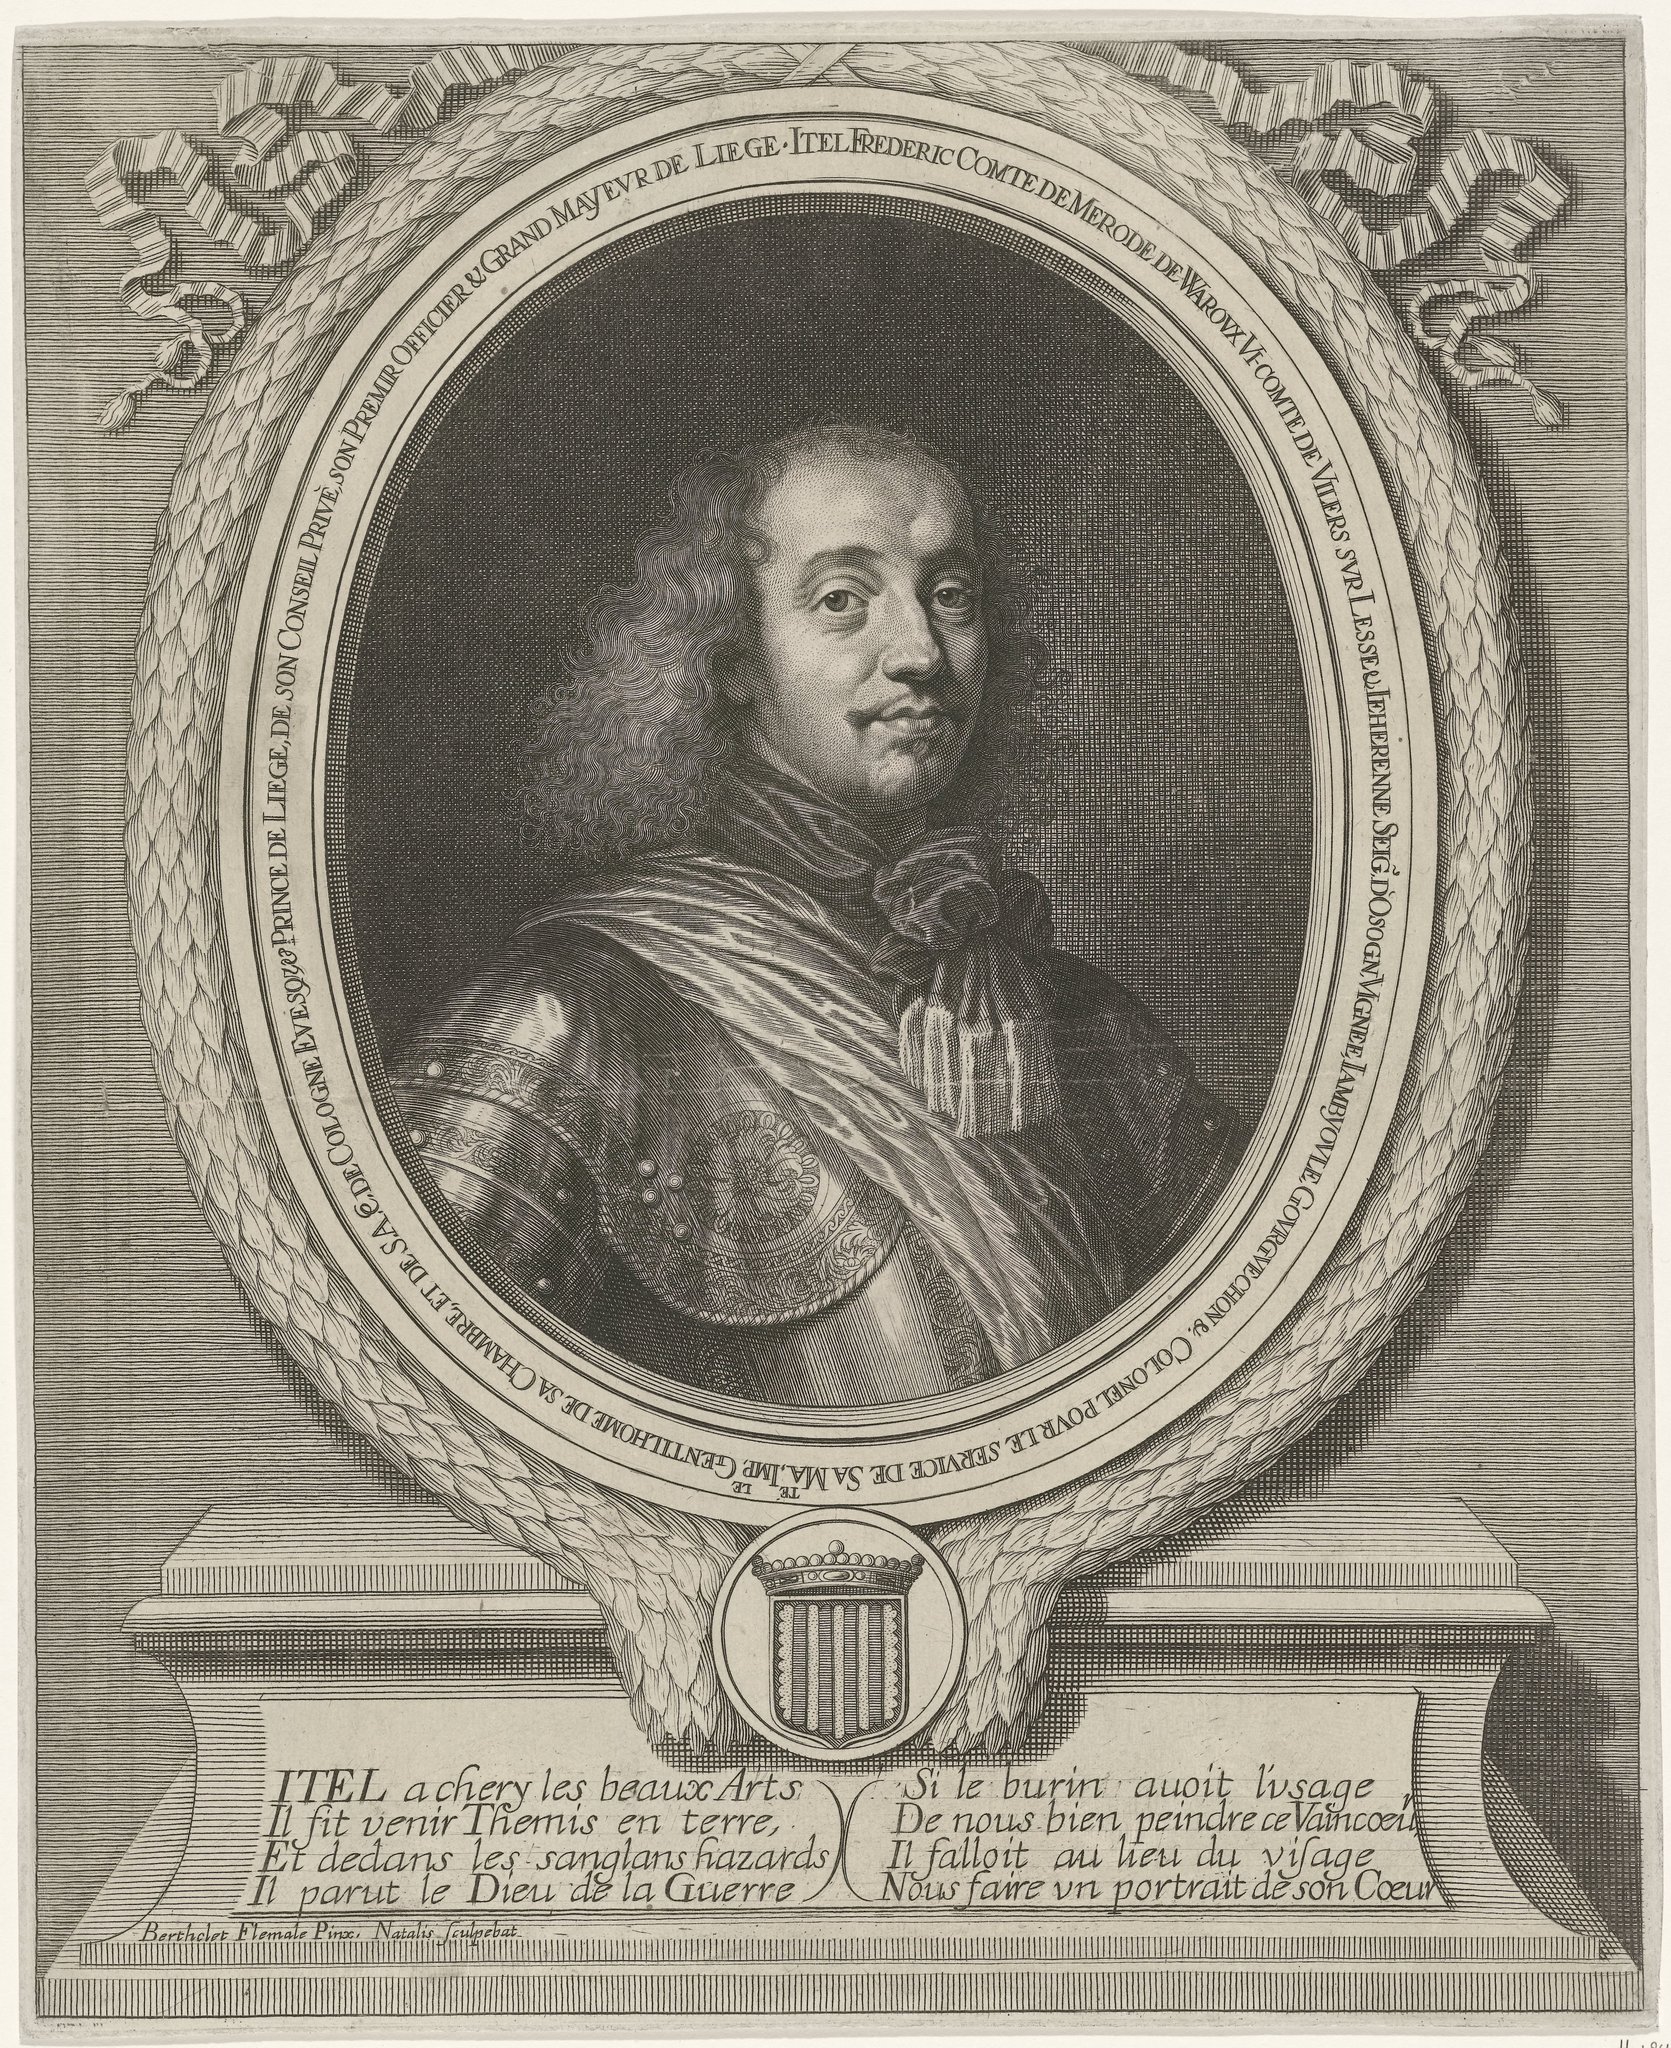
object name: print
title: Portret van Itel-Frédéric de Merode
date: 1620-1668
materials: paper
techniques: engraving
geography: liège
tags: itel-frédéric de merode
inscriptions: collector's mark: Lugt 2228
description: Portret van Itel-Frédéric de Merode, graaf van Merode en Waroux, gekleed in harnas en met een sjerp over de schouder. Buste naar recht in ovaal met randschrift, omlijst door een lauwerkrans. Midden onder de lijst het wapen van de familie de Merode. Onderaan twee vierregelige verzen in het Frans.